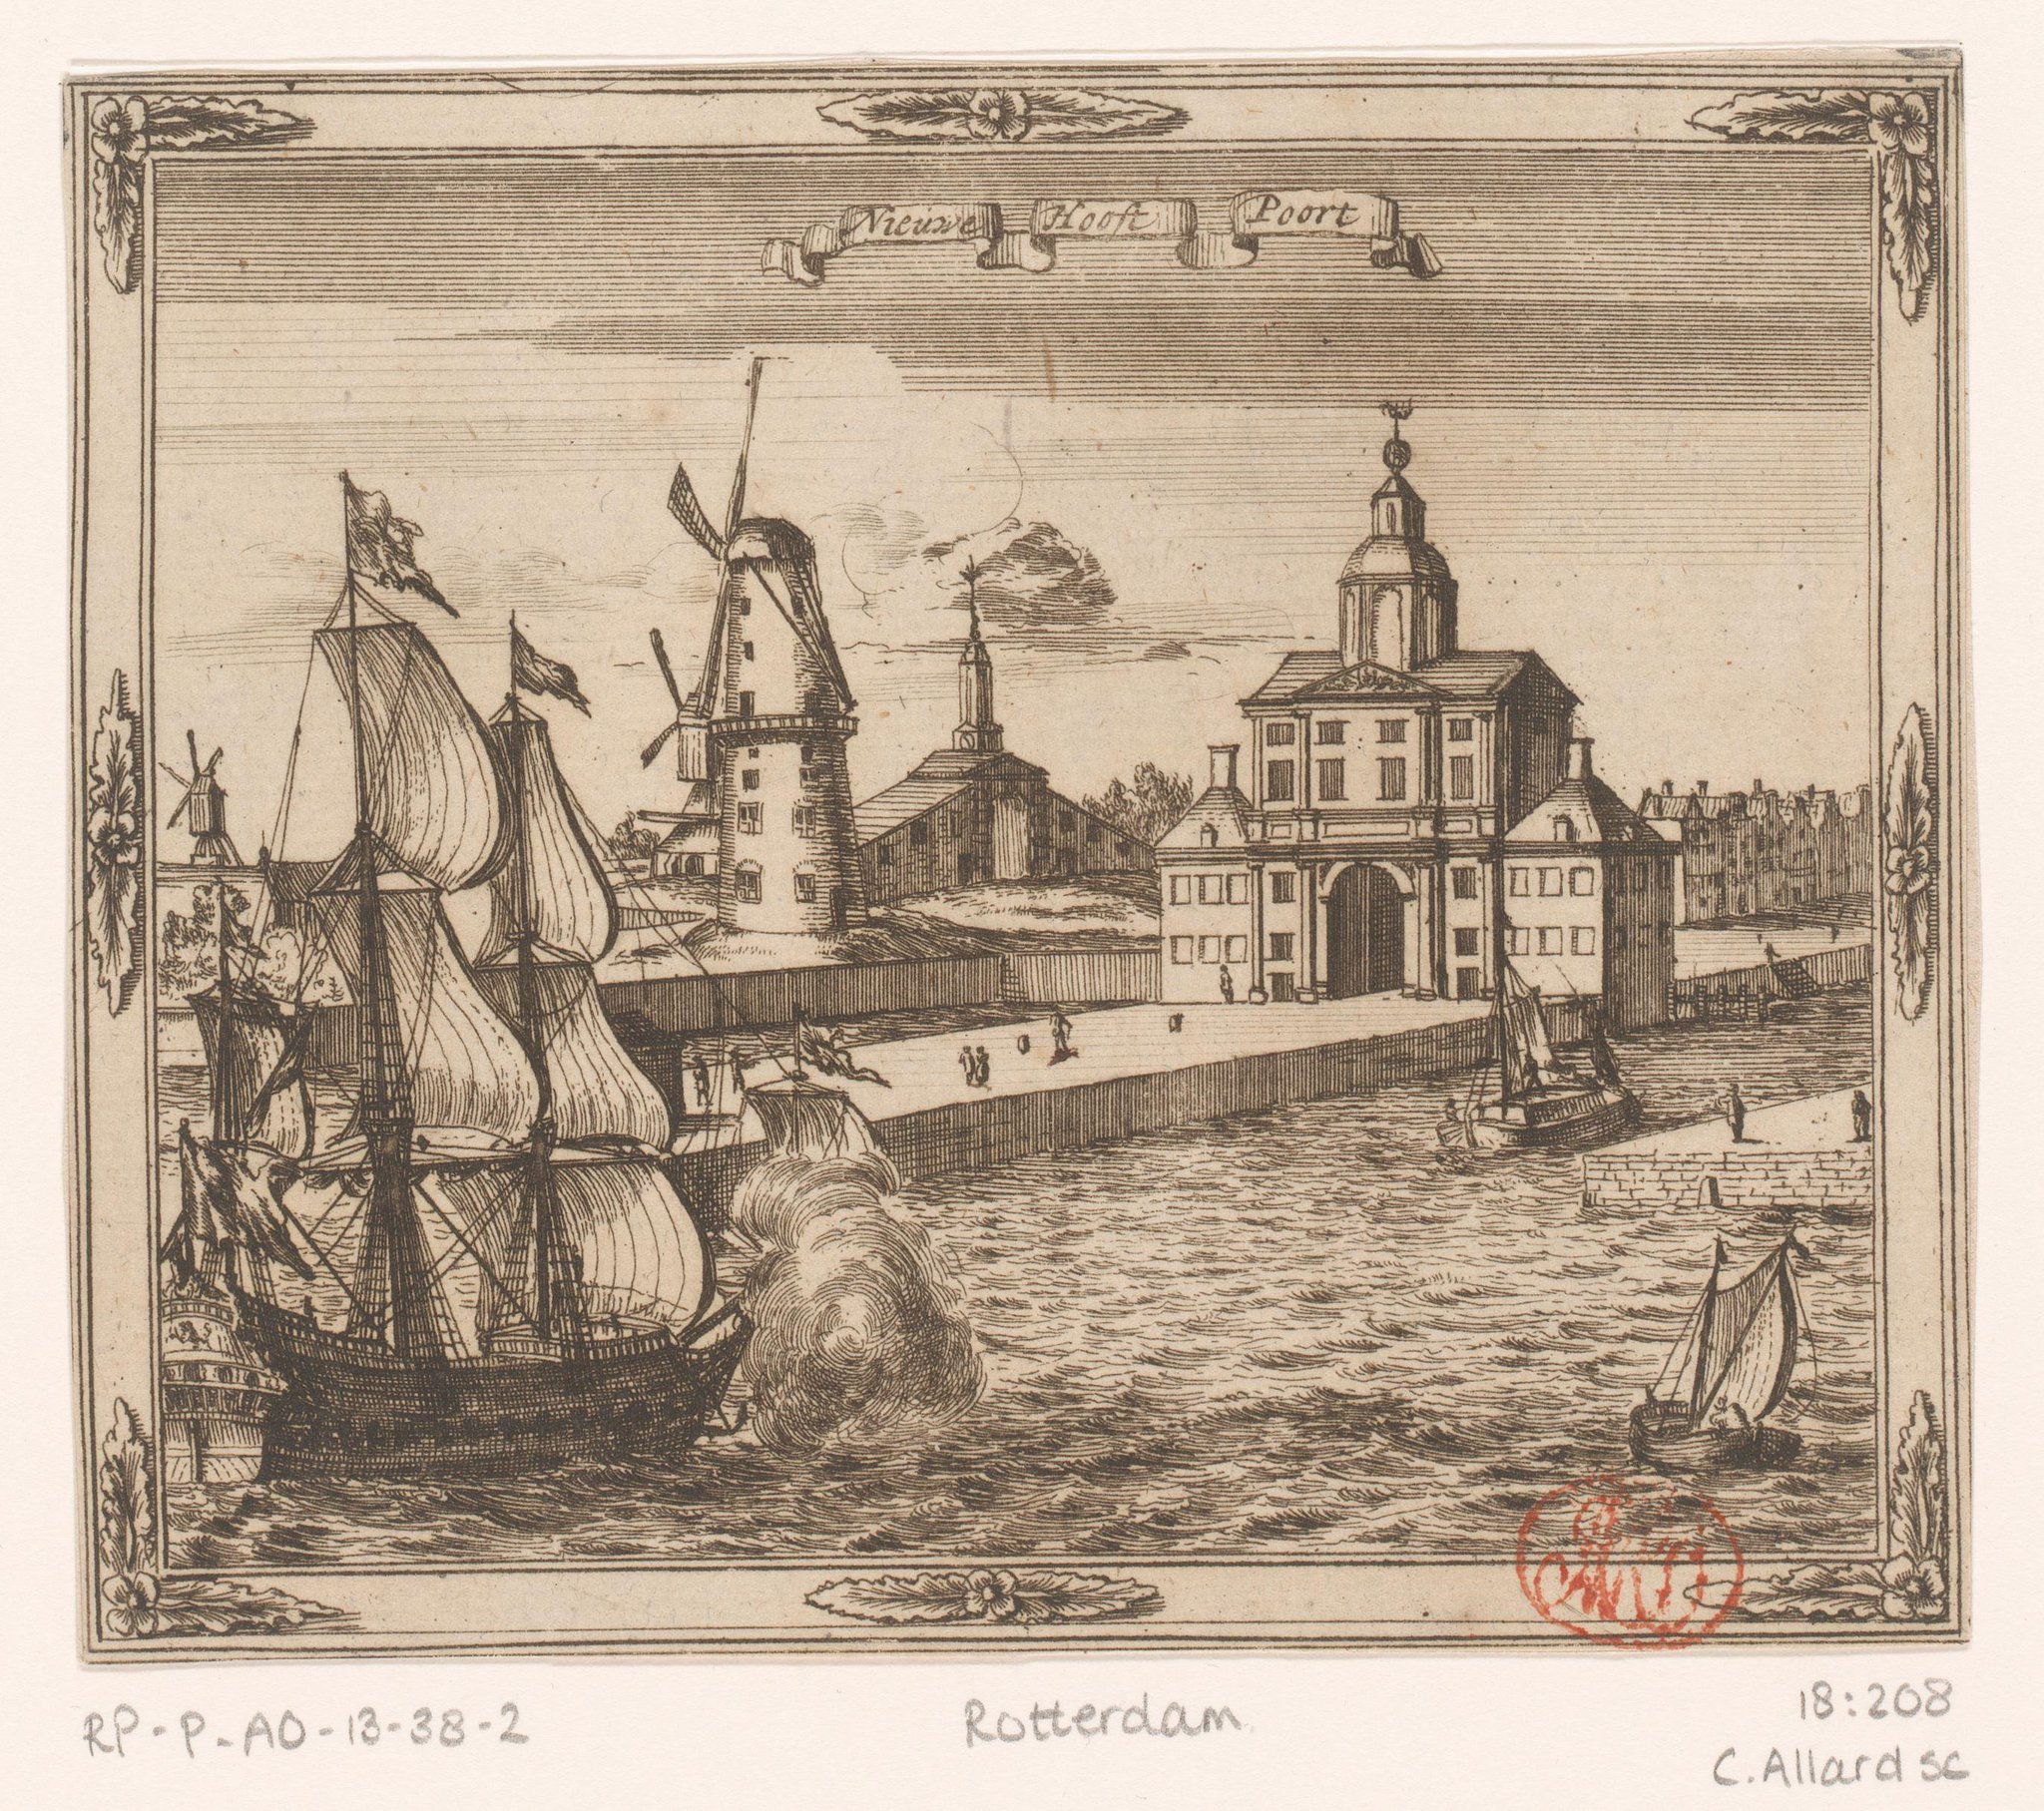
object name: print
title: Les principaux edifices et vues de la ville de Rotterdam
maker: jacobus harrewijn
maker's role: print maker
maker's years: 1660-1740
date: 1715-1730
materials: paper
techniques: etching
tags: harbour, sailing-ship, sailing-boat, city-gate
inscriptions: collector's mark: Lugt 2228, collector's mark: Lugt 195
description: Prent vermoedelijk eerst met dertien andere stadsgezichten uitgegeven als onderdeel van de sierrand van – in ieder geval de derde staat en mogelijk ook de tweede van – de plattegrond 'Tabula Roterodami Novissima' (zie RP-P-AO-13-11). Later nog een keer als onderdeel van een prentserie uitgegeven: Les principaux edifices et vues de la ville de Rotterdam. Le tout fidèlement dessiné sur les lieux. Leiden: Pieter van der Aa, s.a. [adres 'dans l'Academie', dus 1715-1730]. De platen zijn voor zover na te gaan ongewijzigd gebleven.